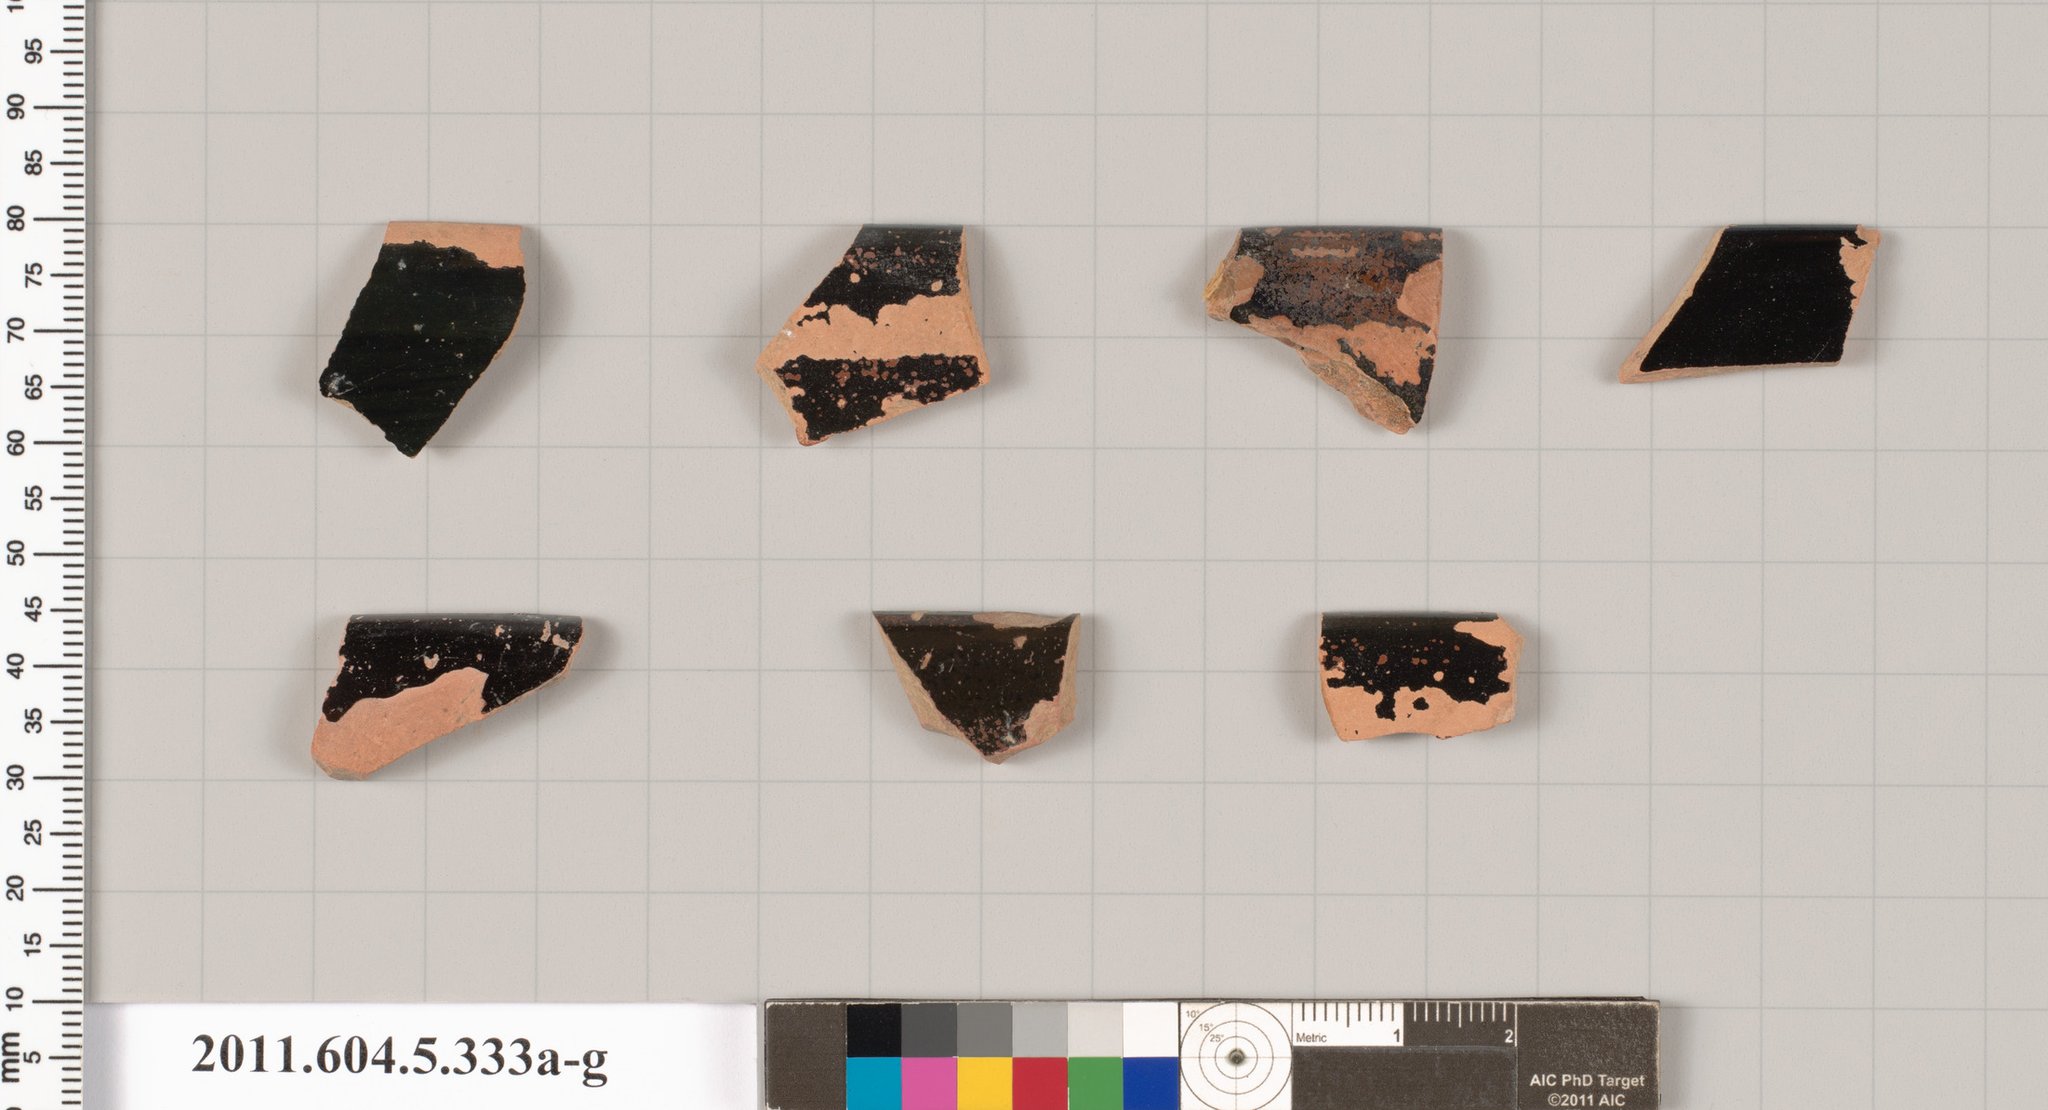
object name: kylix fragment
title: Terracotta rim fragments of kylikes (drinking cups)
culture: greek, attic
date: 600-401 BCE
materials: terracotta